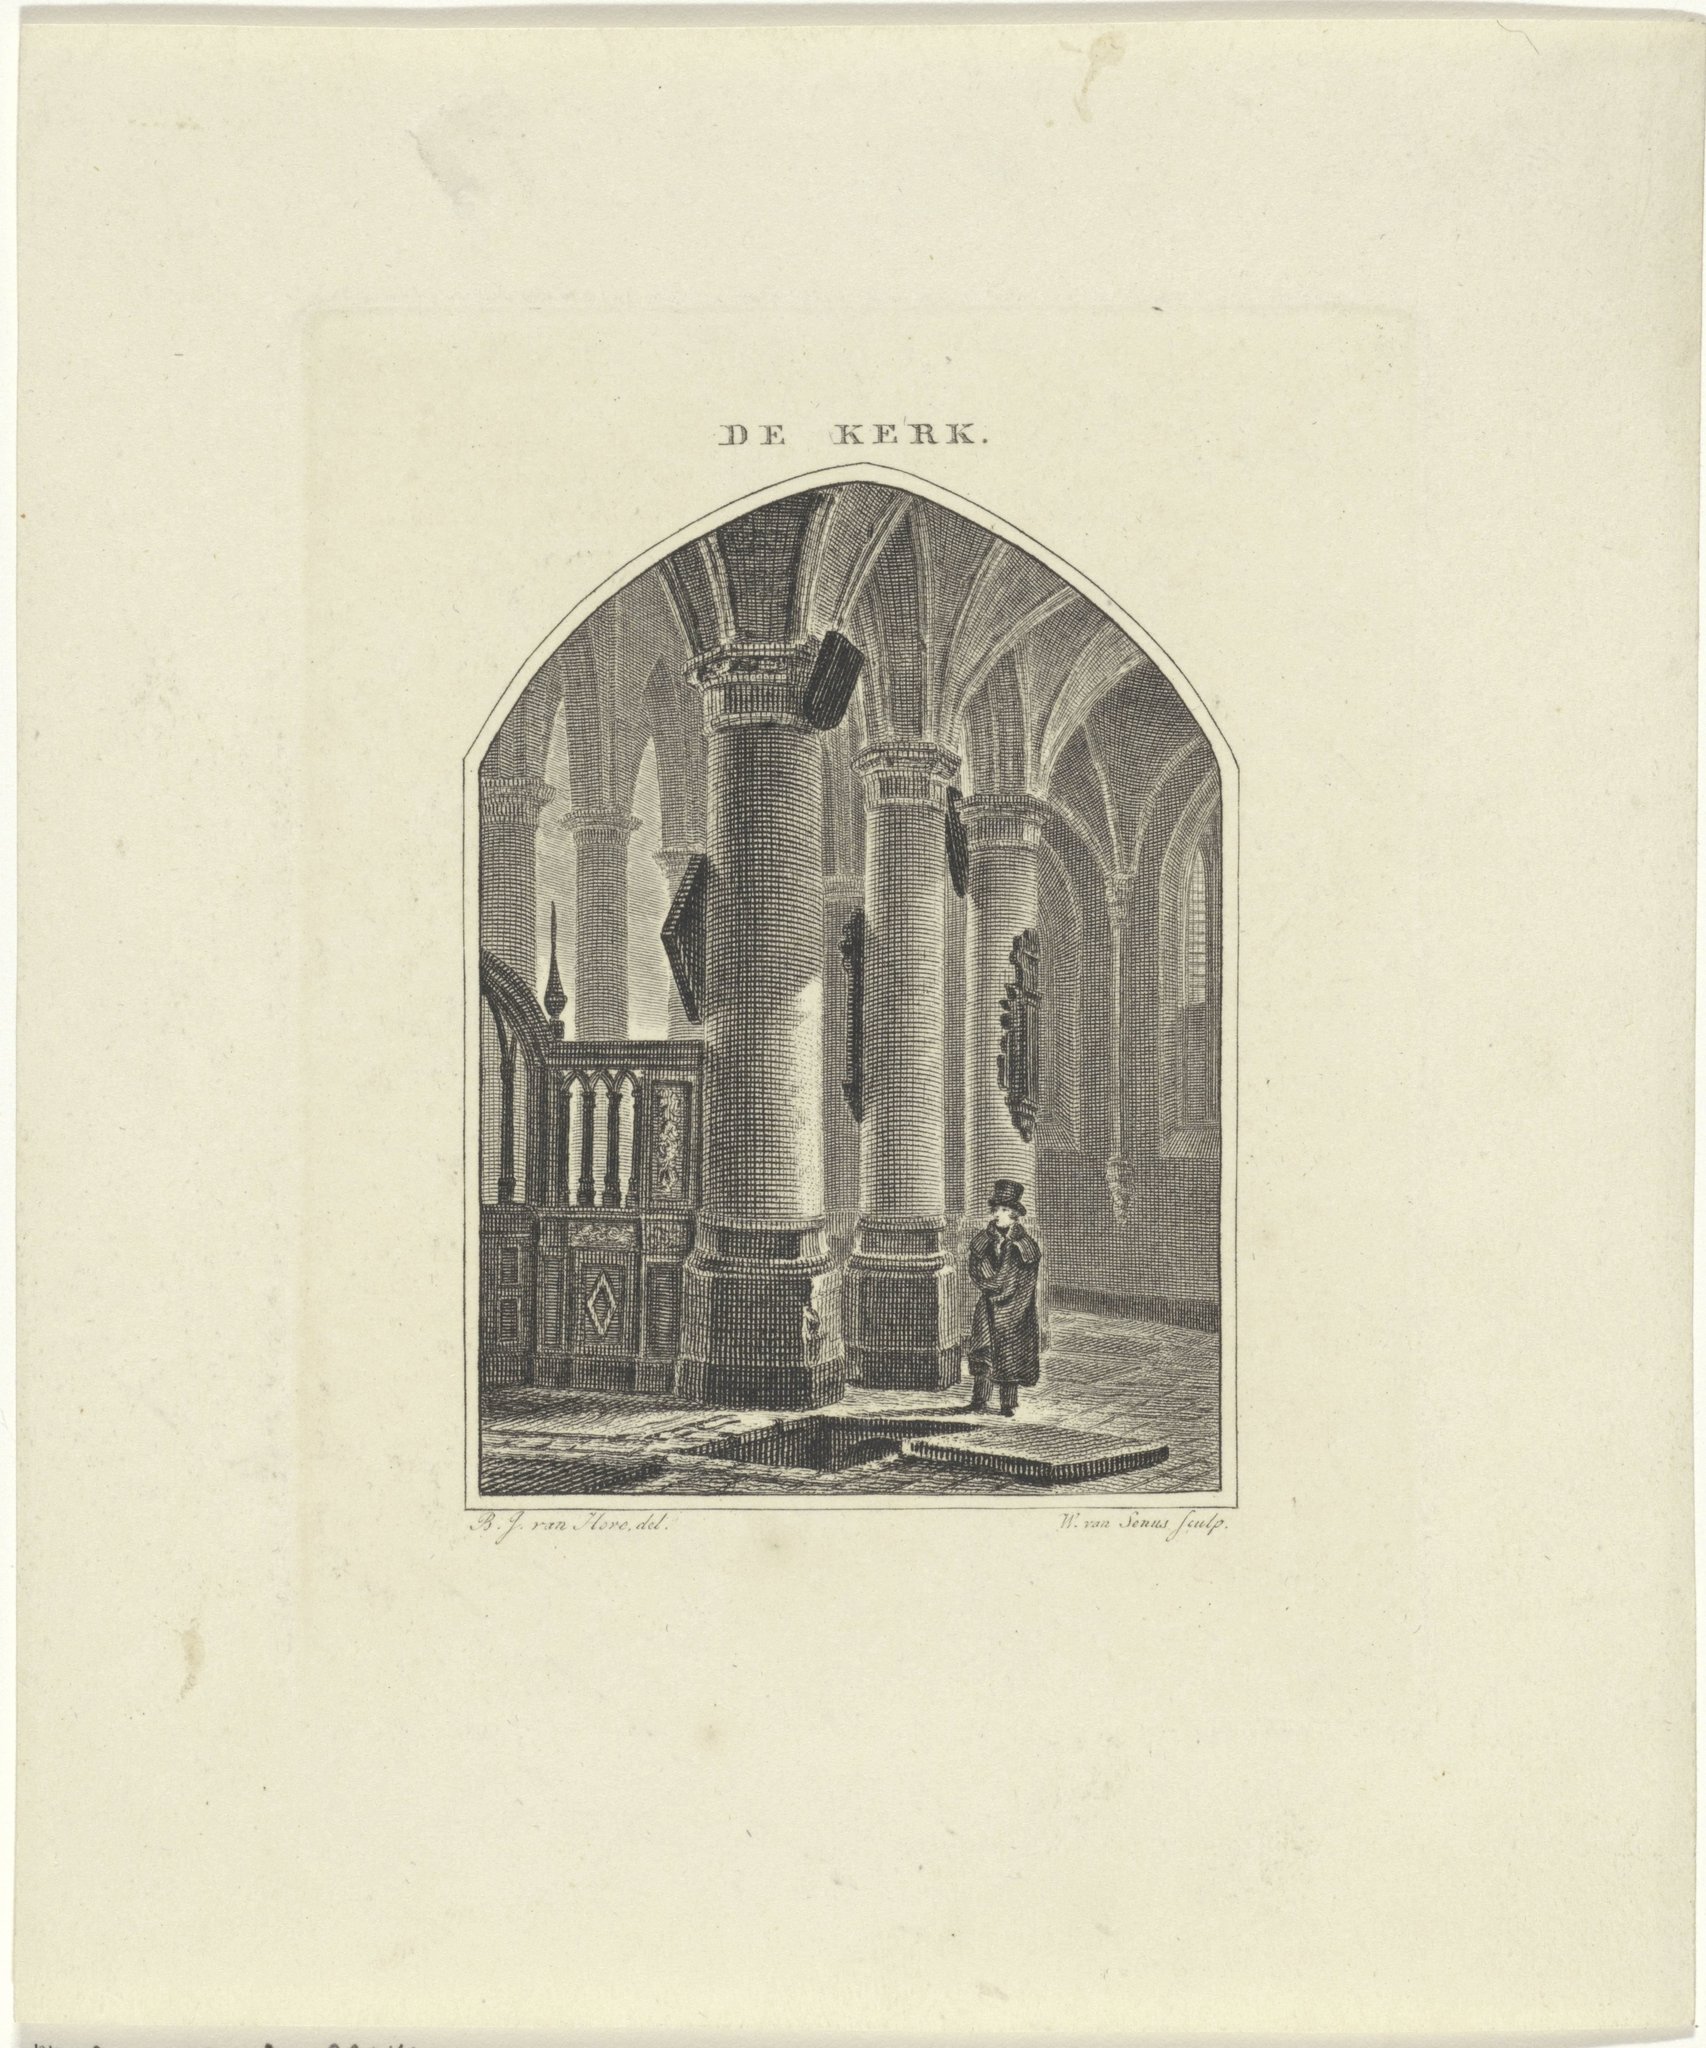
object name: print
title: Man bij een open graf in een kerk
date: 1800-1851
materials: paper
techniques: engraving, etching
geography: netherlands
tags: grave, tomb, interior of church, opening of grave, exhumation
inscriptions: collector's mark: Lugt 2228